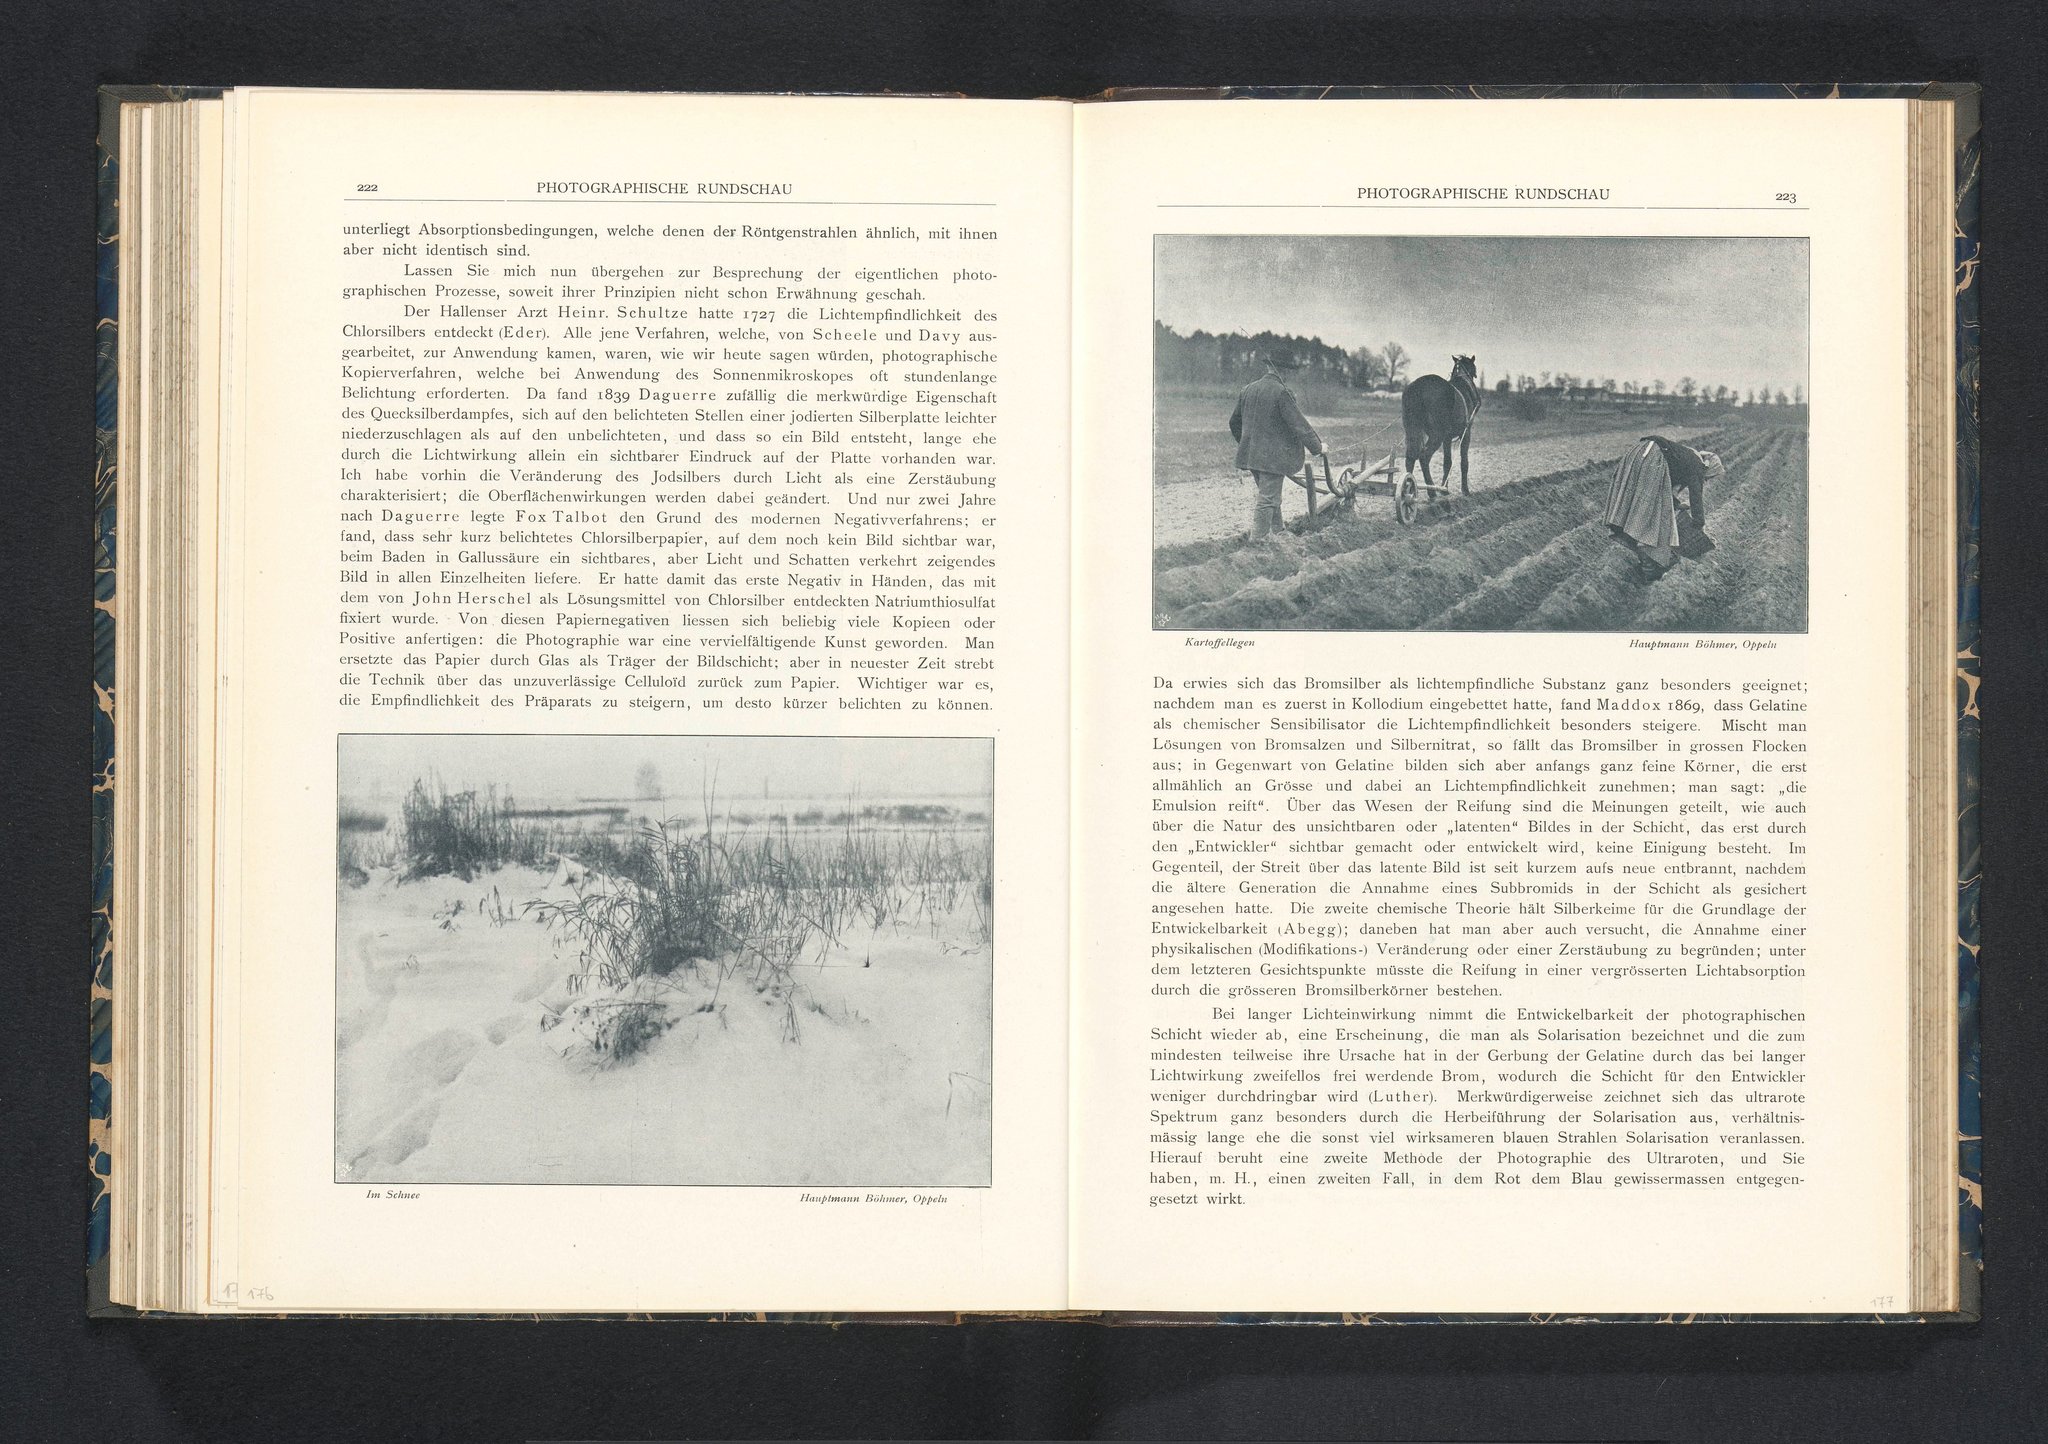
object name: page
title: Kartoffellegen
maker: hauptmann a. böhmer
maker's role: draughtsman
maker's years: 1860-1908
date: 1896-1901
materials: paper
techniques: autotype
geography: berlin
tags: farmers, farmers - aa - female farmer, farmer's wife